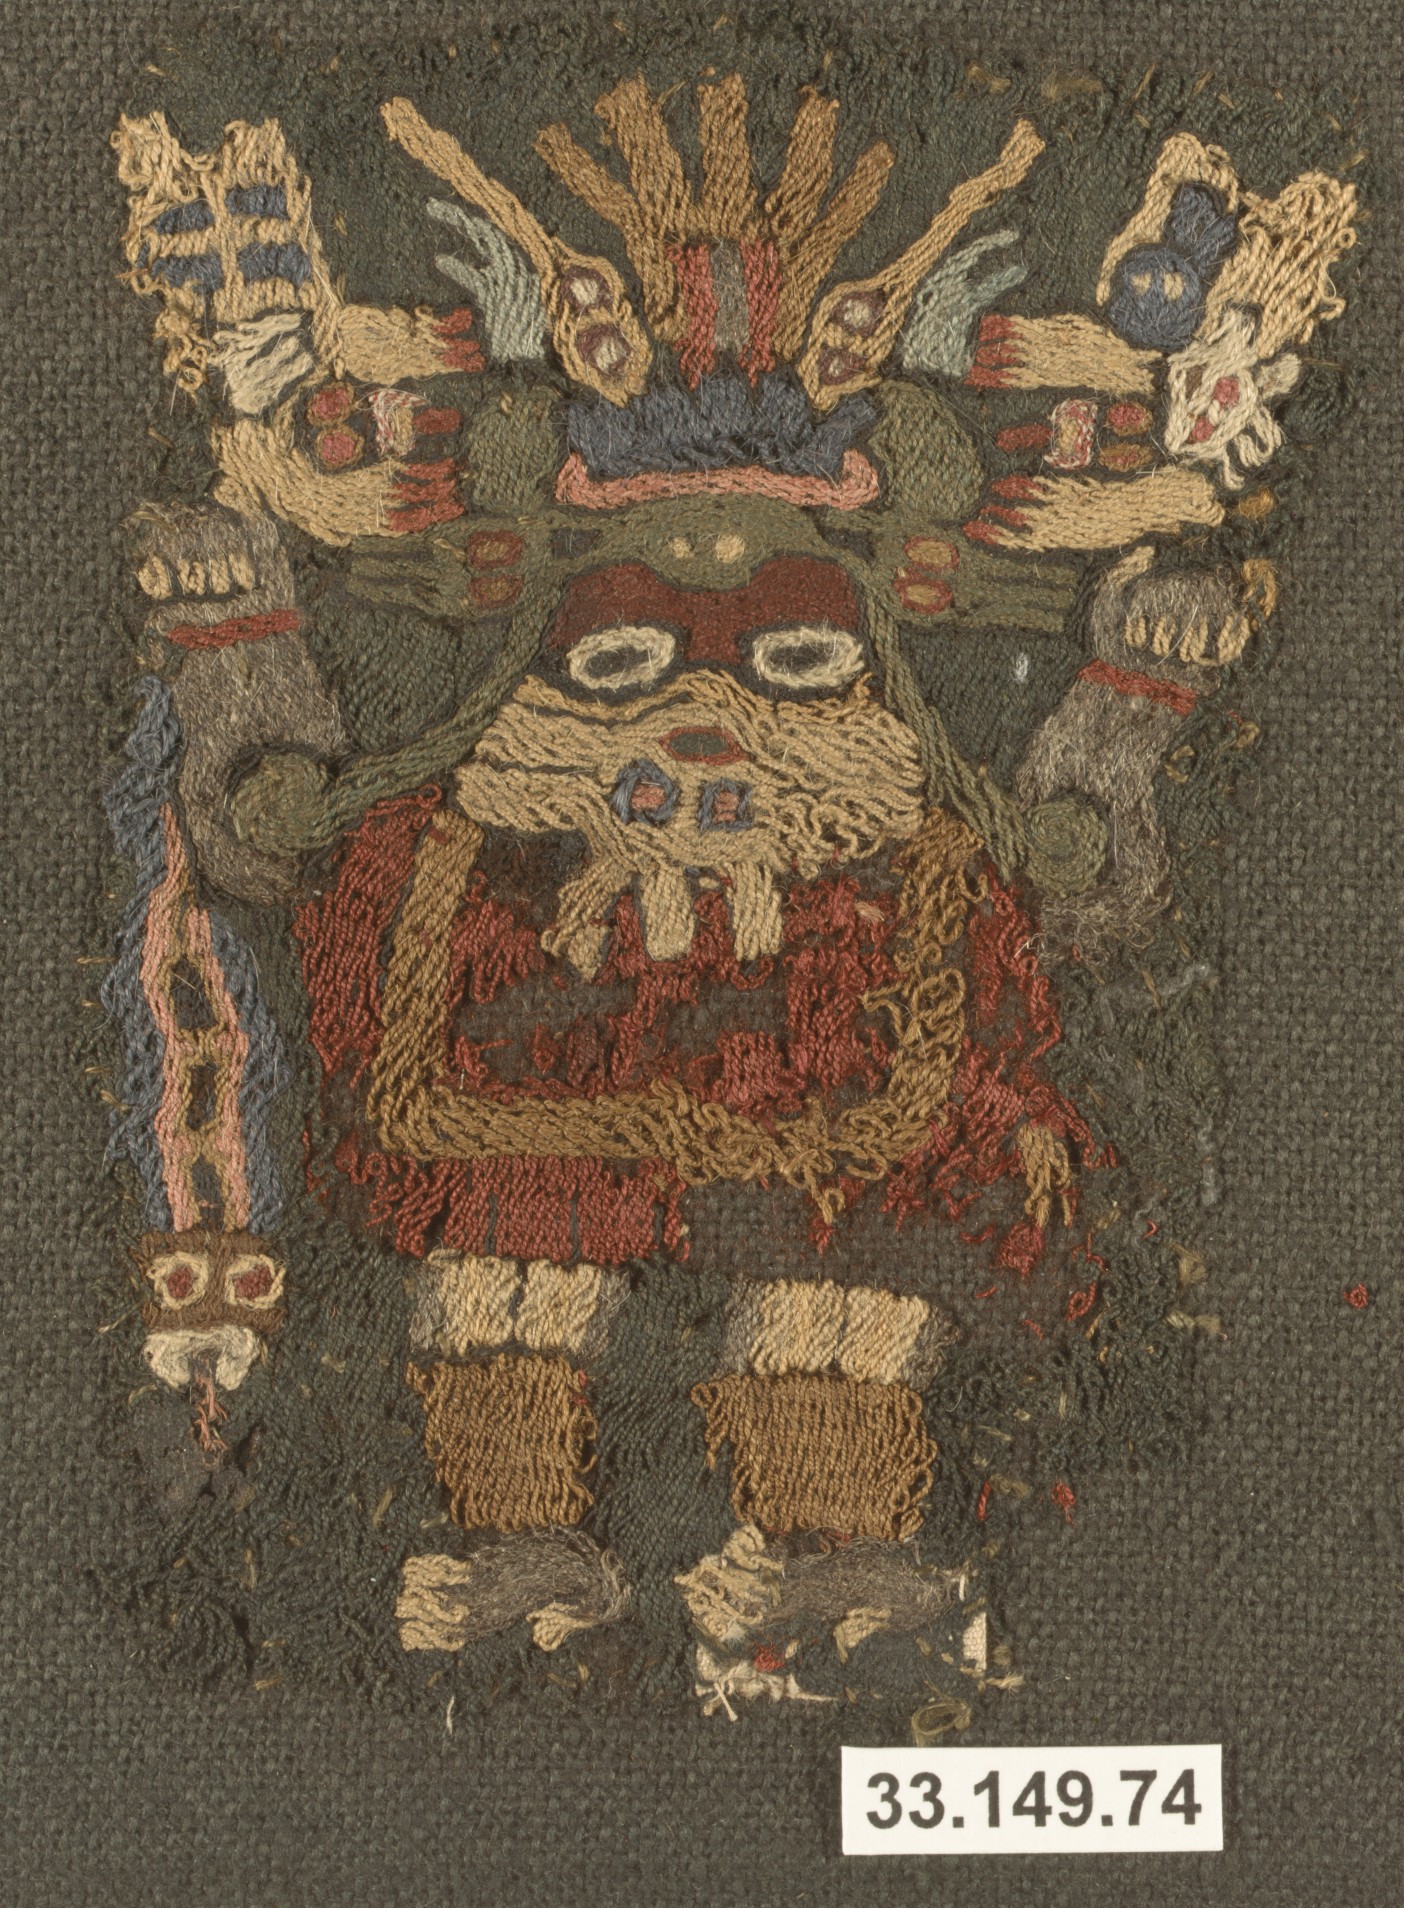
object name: mantle fragment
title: Embroidered Mantle Fragment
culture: paracas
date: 300-101 BCE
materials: animal fiber, cotton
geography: peru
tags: heads,mythical creatures